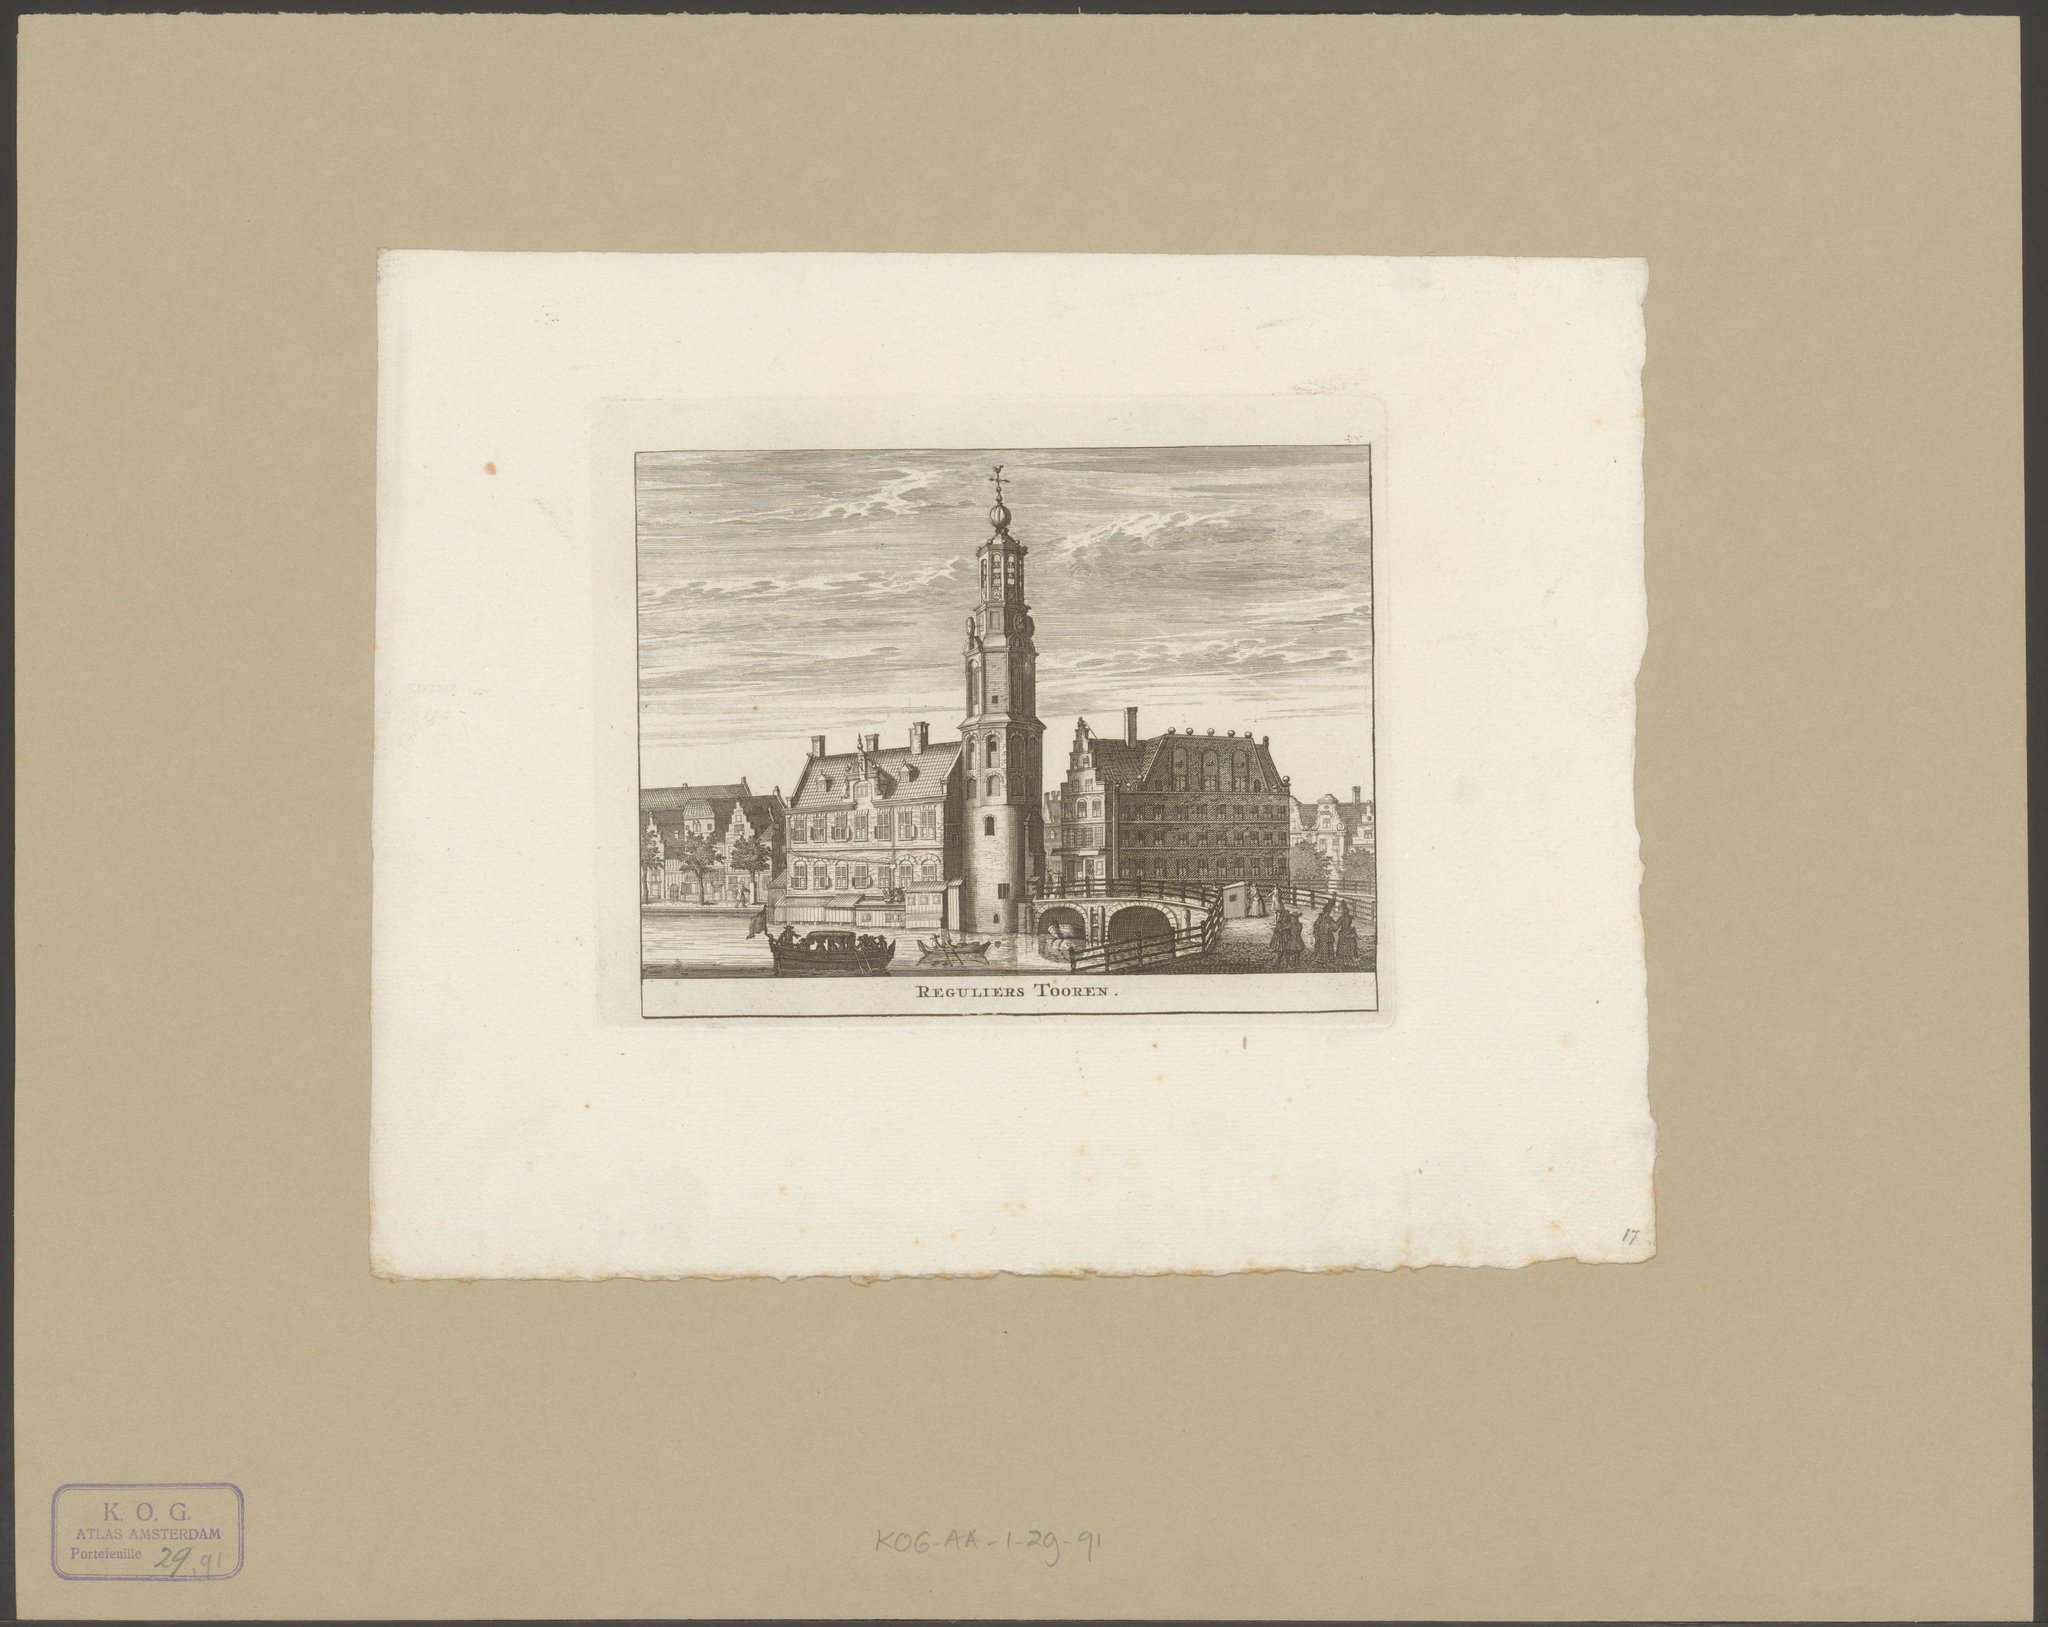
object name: print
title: Gezicht op de Munttoren te Amsterdam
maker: Anonymous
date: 1726-1751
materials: paper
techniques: engraving, etching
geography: northern netherlands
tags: tower, clock tower ~ monumental adornment, rowing-boat, canoe, etc., canals, waters (in city) (+ city(-scape) with figures, staffage)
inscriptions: collector's mark: Lugt 1641b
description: Prent mogelijk uit: Hoorn, Nicolaas ten. Wegwyzer door Amsterdam zynde eene beknopte verhandeling van desselfs eerste opkomst, vergrootingen, en teegenwoordigen staat (...). Amsterdam: Nicolaas ten Hoorn, 1726. Of uit: Hoorn, Nicolaas ten. Wegwyzer, of korte beschryvinge van de stadt Amsterdam, zynde eene beknopte verhandeling van desselfs eerste opkomst, vergrootingen, en teegenwoordigen staat (...). Amsterdam: erven J. Ratelband & Co, 1737. Of uit: Hoorn, Nicolaas ten. Wegwyzer of korte beschryvinge der stad Amsterdam, zynde eene beknopte verhandeling van derzelver eerste opkomst, vergrootingen, en tegenwoordigen staat (...). Amsterdam: Pieter Meyer, 1751. Eerste staat van prent, genummerd 278, gebruikt in: Hoorn, Nicolaas ten. Wegwyzer door Amsterdam zynde eene beknopte verhandeling van desselfs eerste opkomst, vergrootingen, en teegenwoordigen staat (...). Amsterdam: Nicolaas ten Hoorn, 1713. En in: Hoorn, Nicolaas ten. Wegwyzer door Amsterdam zynde eene beknopte verhandeling van desselfs eerste opkomst, vergrootingen, en teegenwoordigen staat (...). Amsterdam: Nicolaas ten Hoorn, 1726.